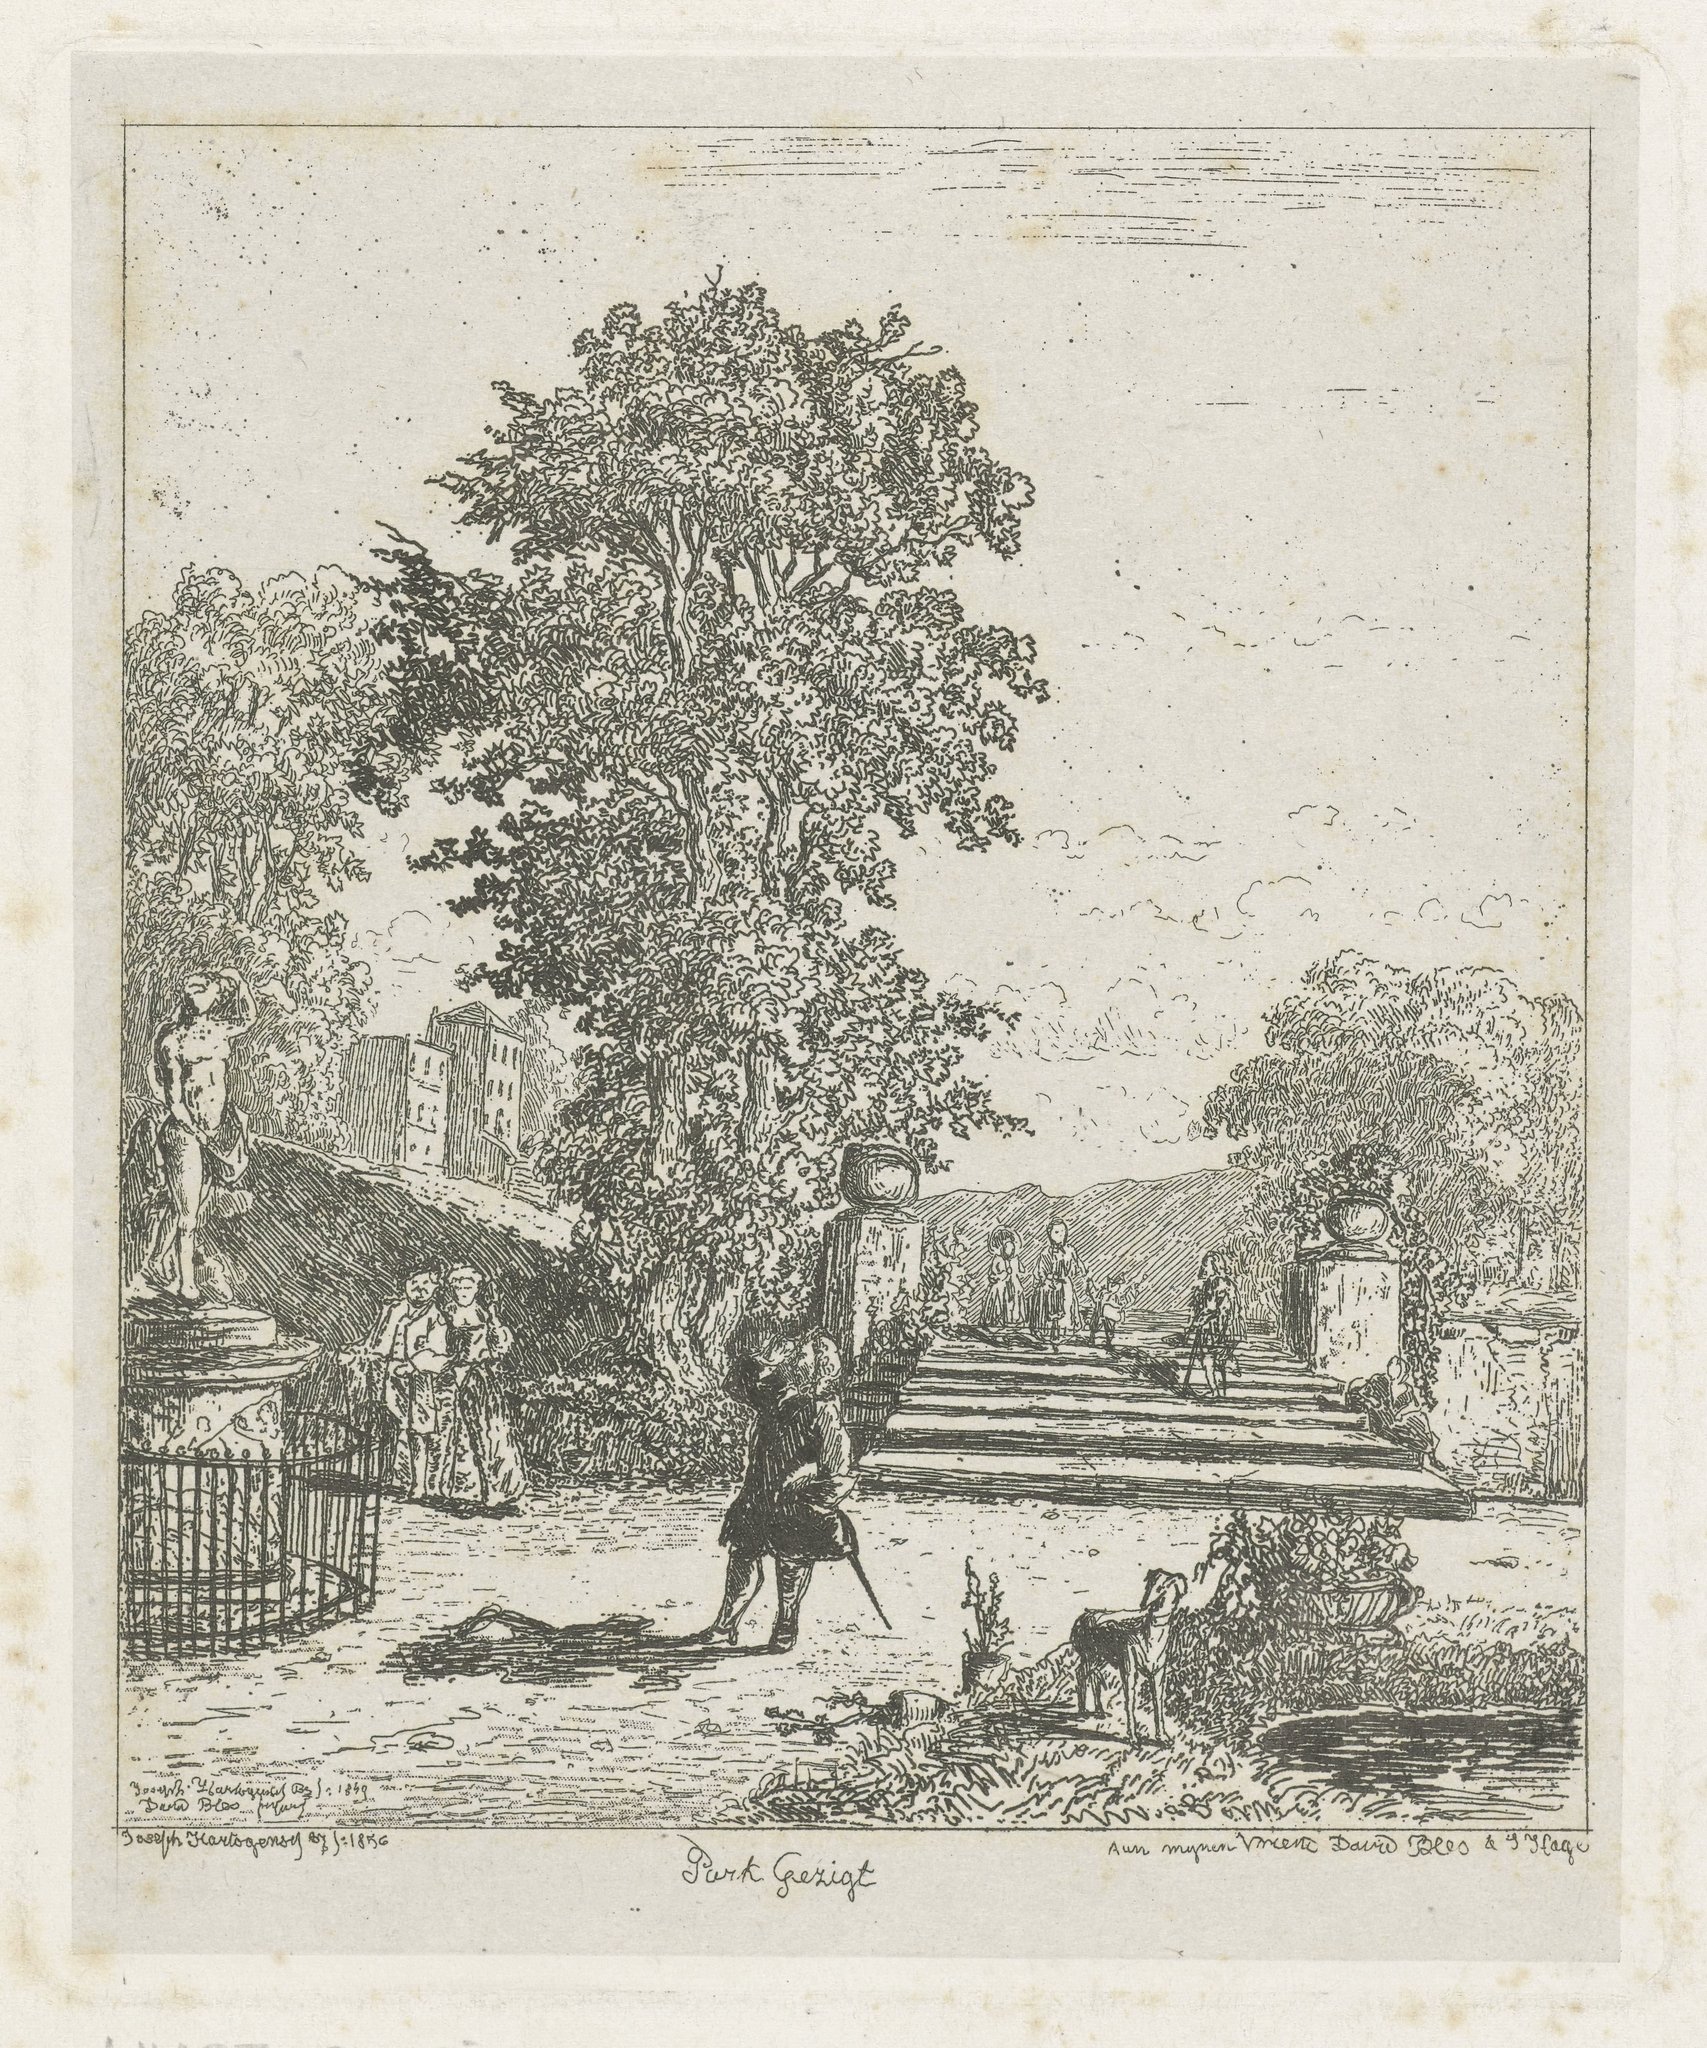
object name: print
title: Figuren in een park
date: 1856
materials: paper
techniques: etching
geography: the hague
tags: park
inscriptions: collector's mark: Lugt 2228